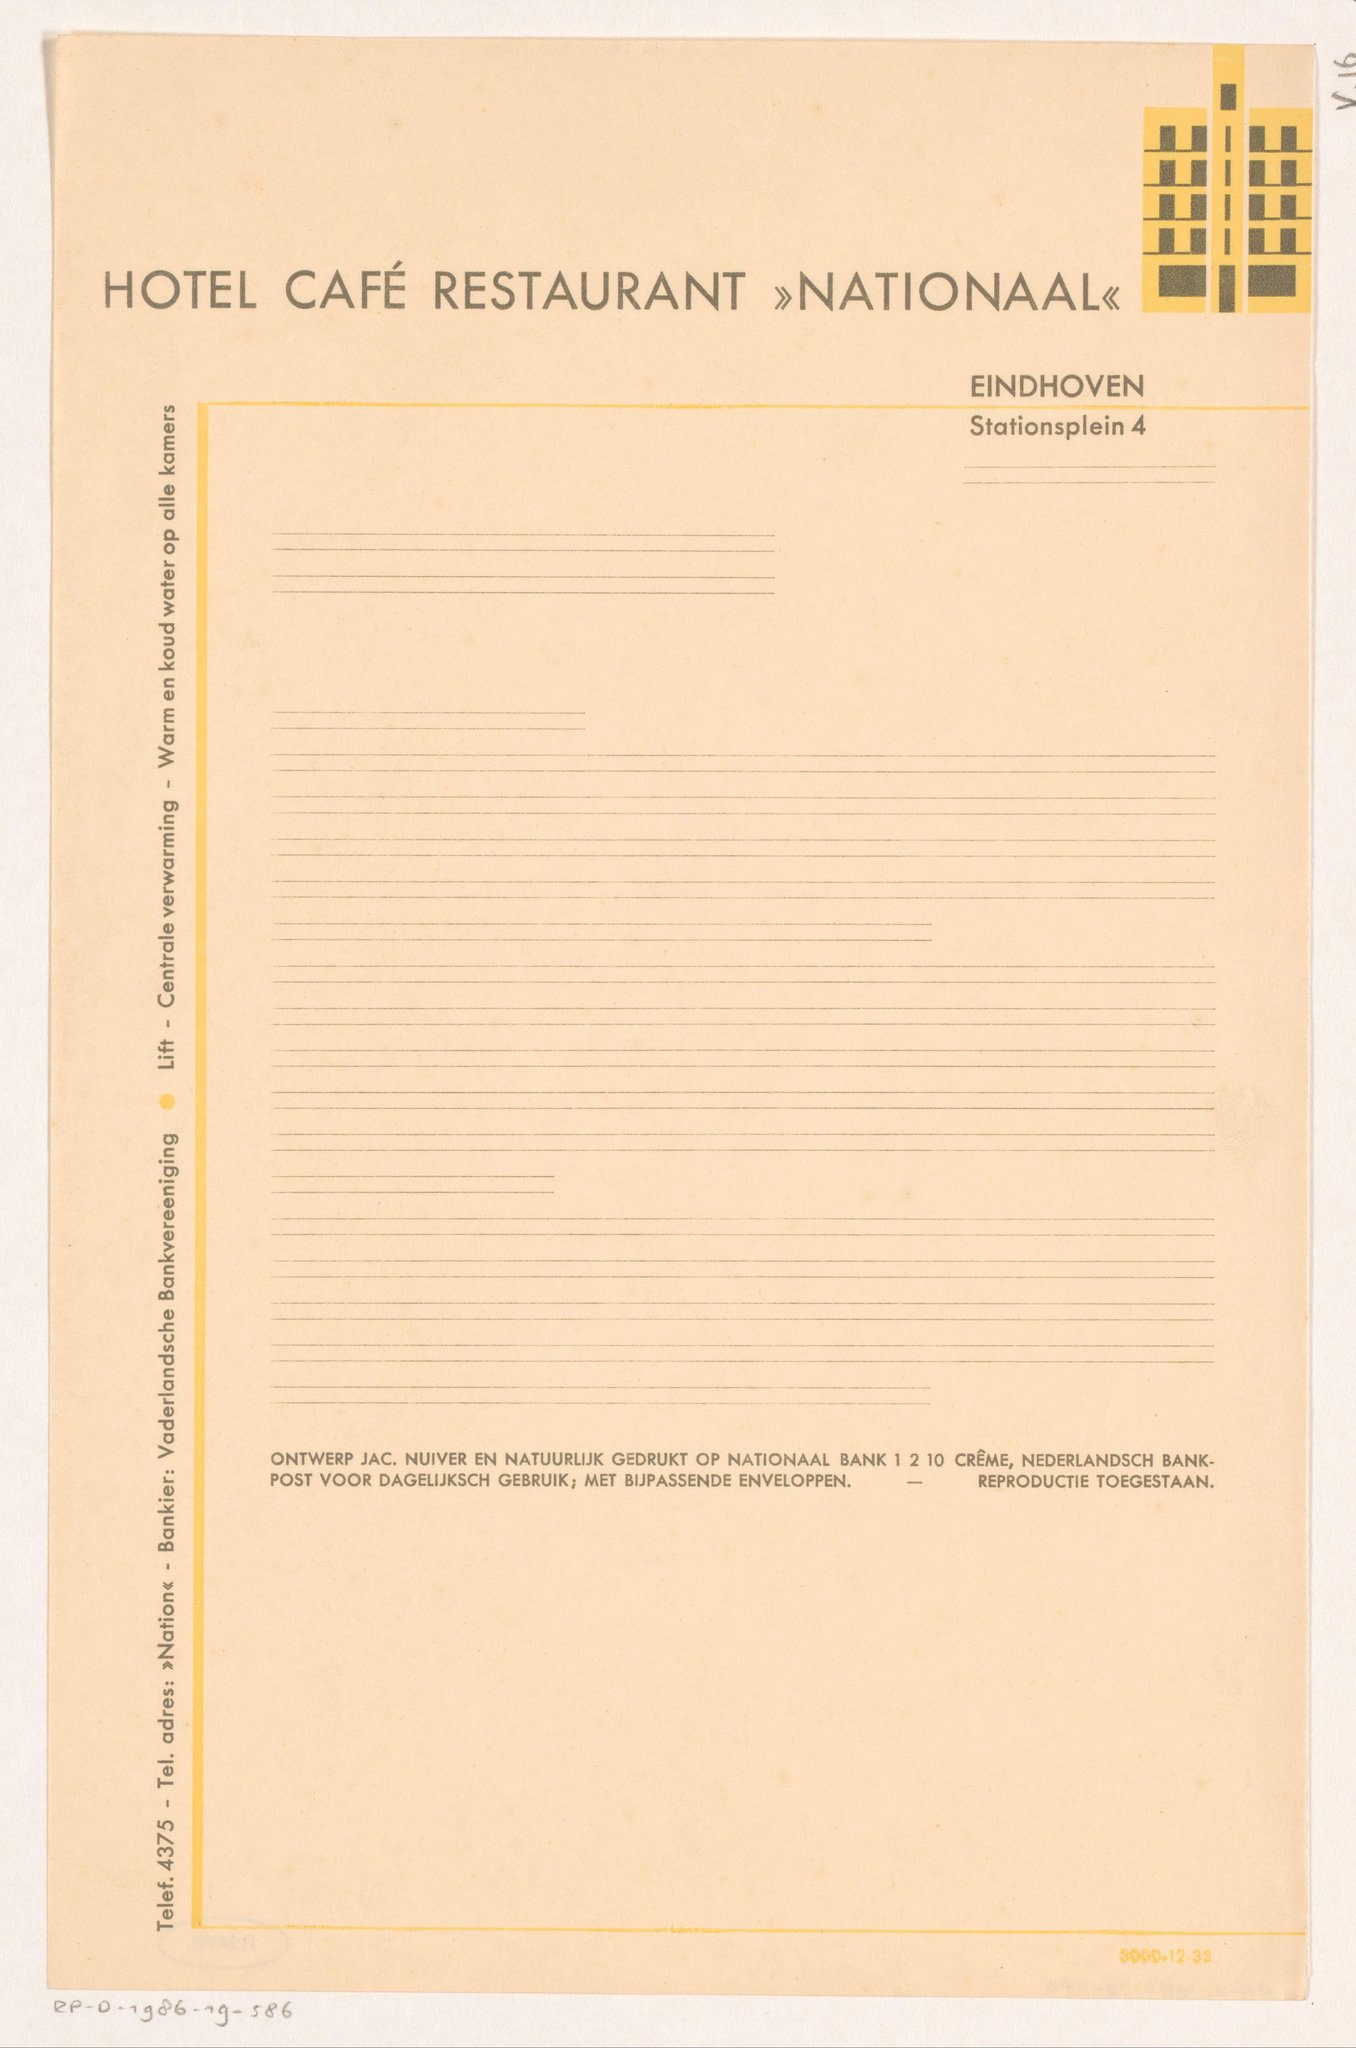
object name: stationery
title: Briefpapier van Hotel Café Restaurant Nationaal te Eindhoven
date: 1902-1953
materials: lined paper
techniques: relief print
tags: civic architecture; edifices; dwellings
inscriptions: collector's mark: ‘R:MVS.’